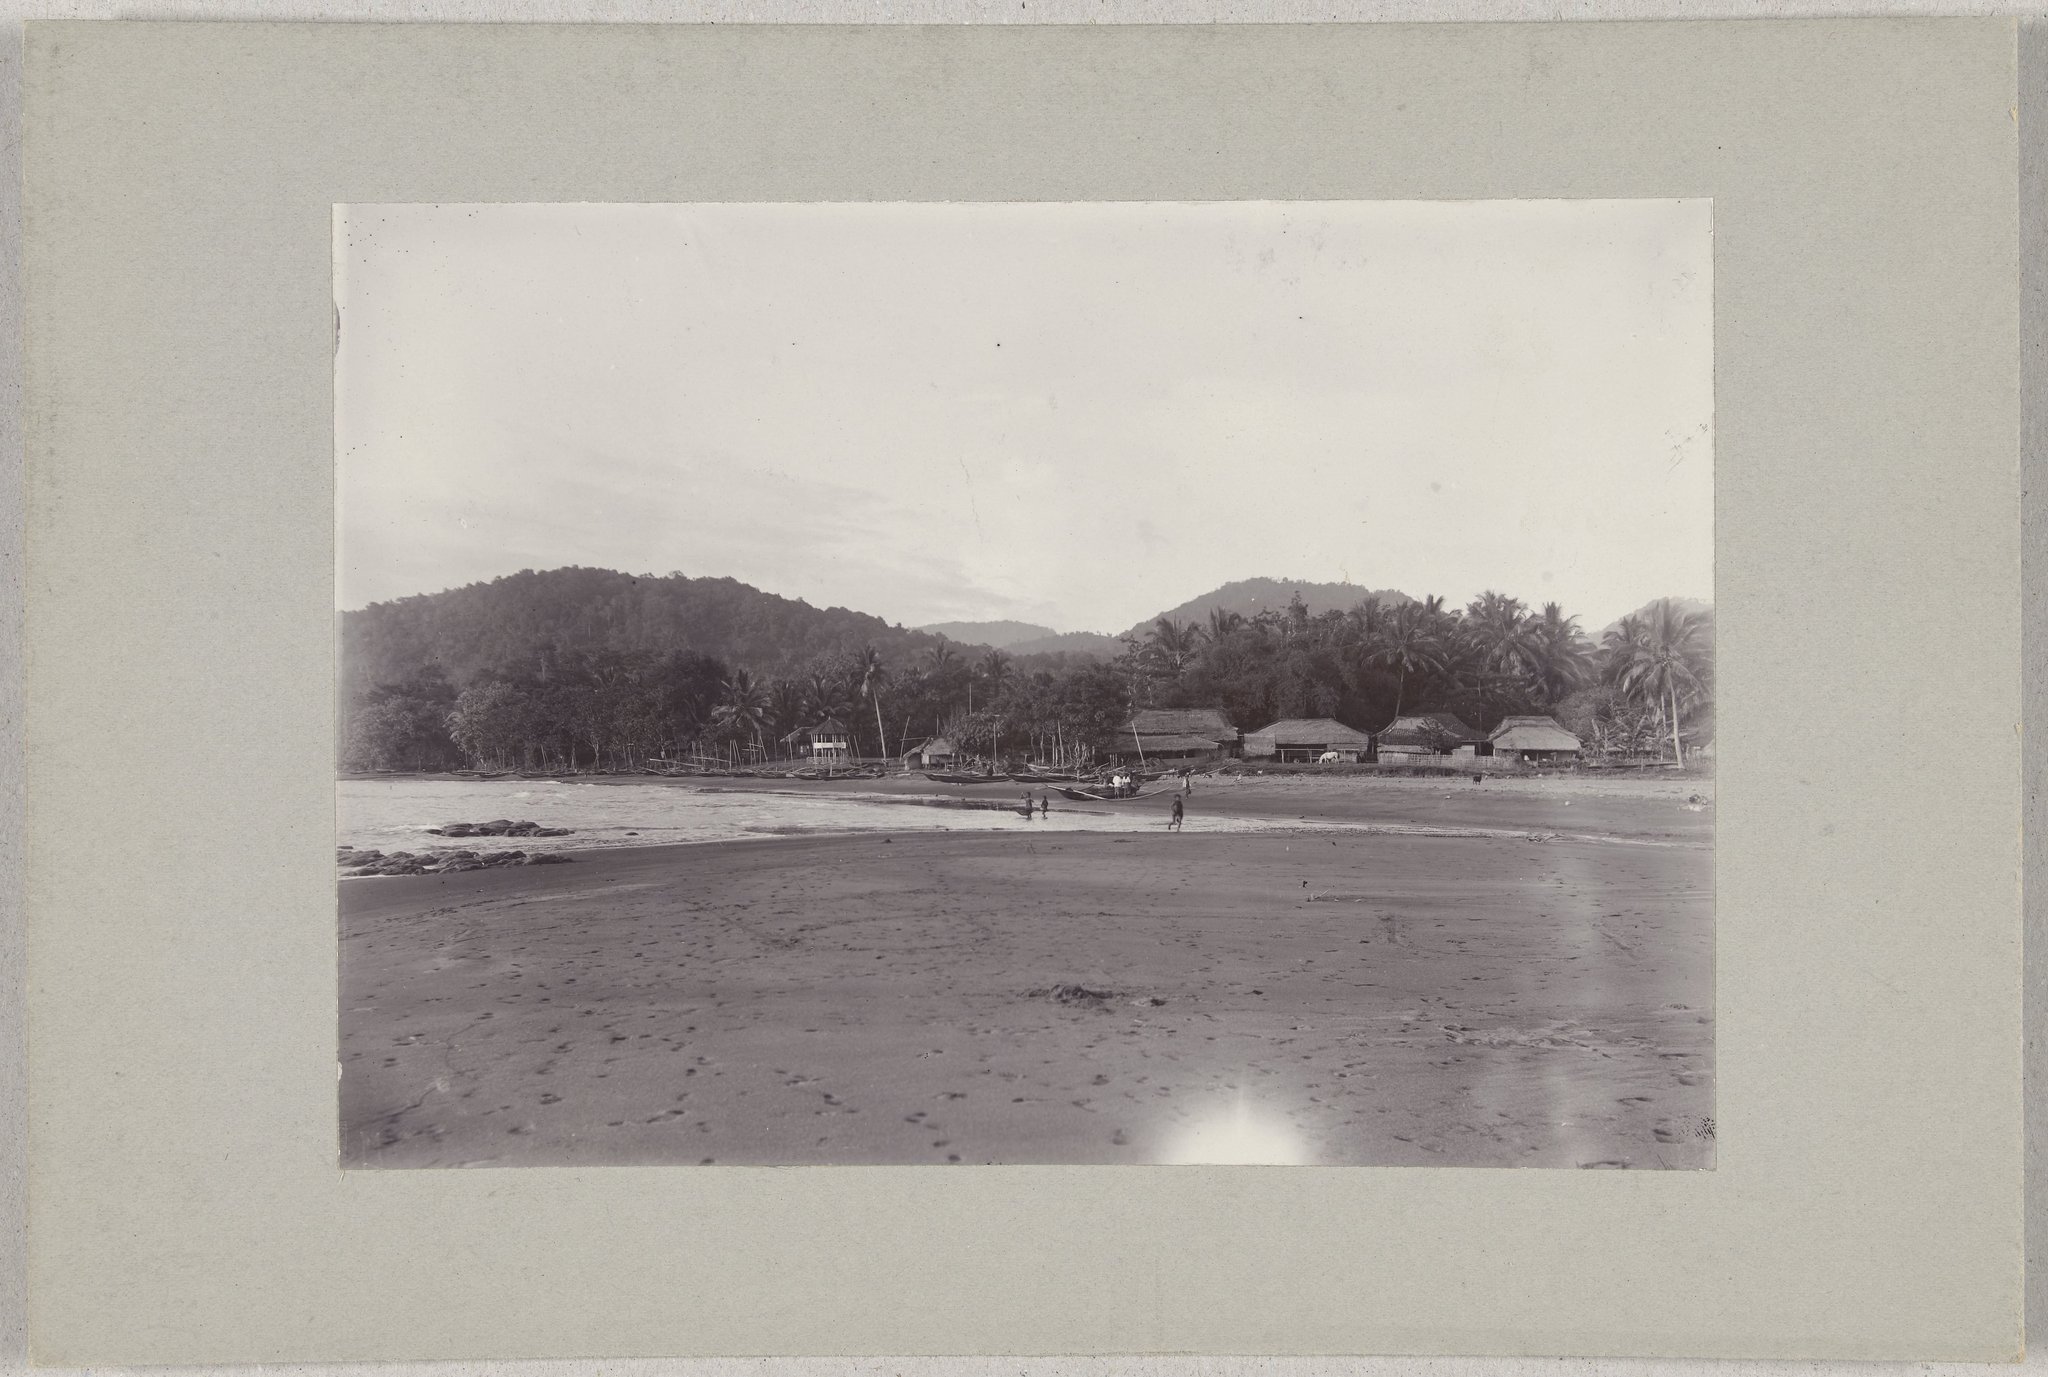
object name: photograph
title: Wijnkoopsbaai in Nederlands-Indië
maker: Anonymous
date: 1895-1915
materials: cardboard, paper, photographic support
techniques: gelatin silver print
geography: dutch east indies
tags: indonesia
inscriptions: annotation: ‘57b Wijnkoopsbaai’